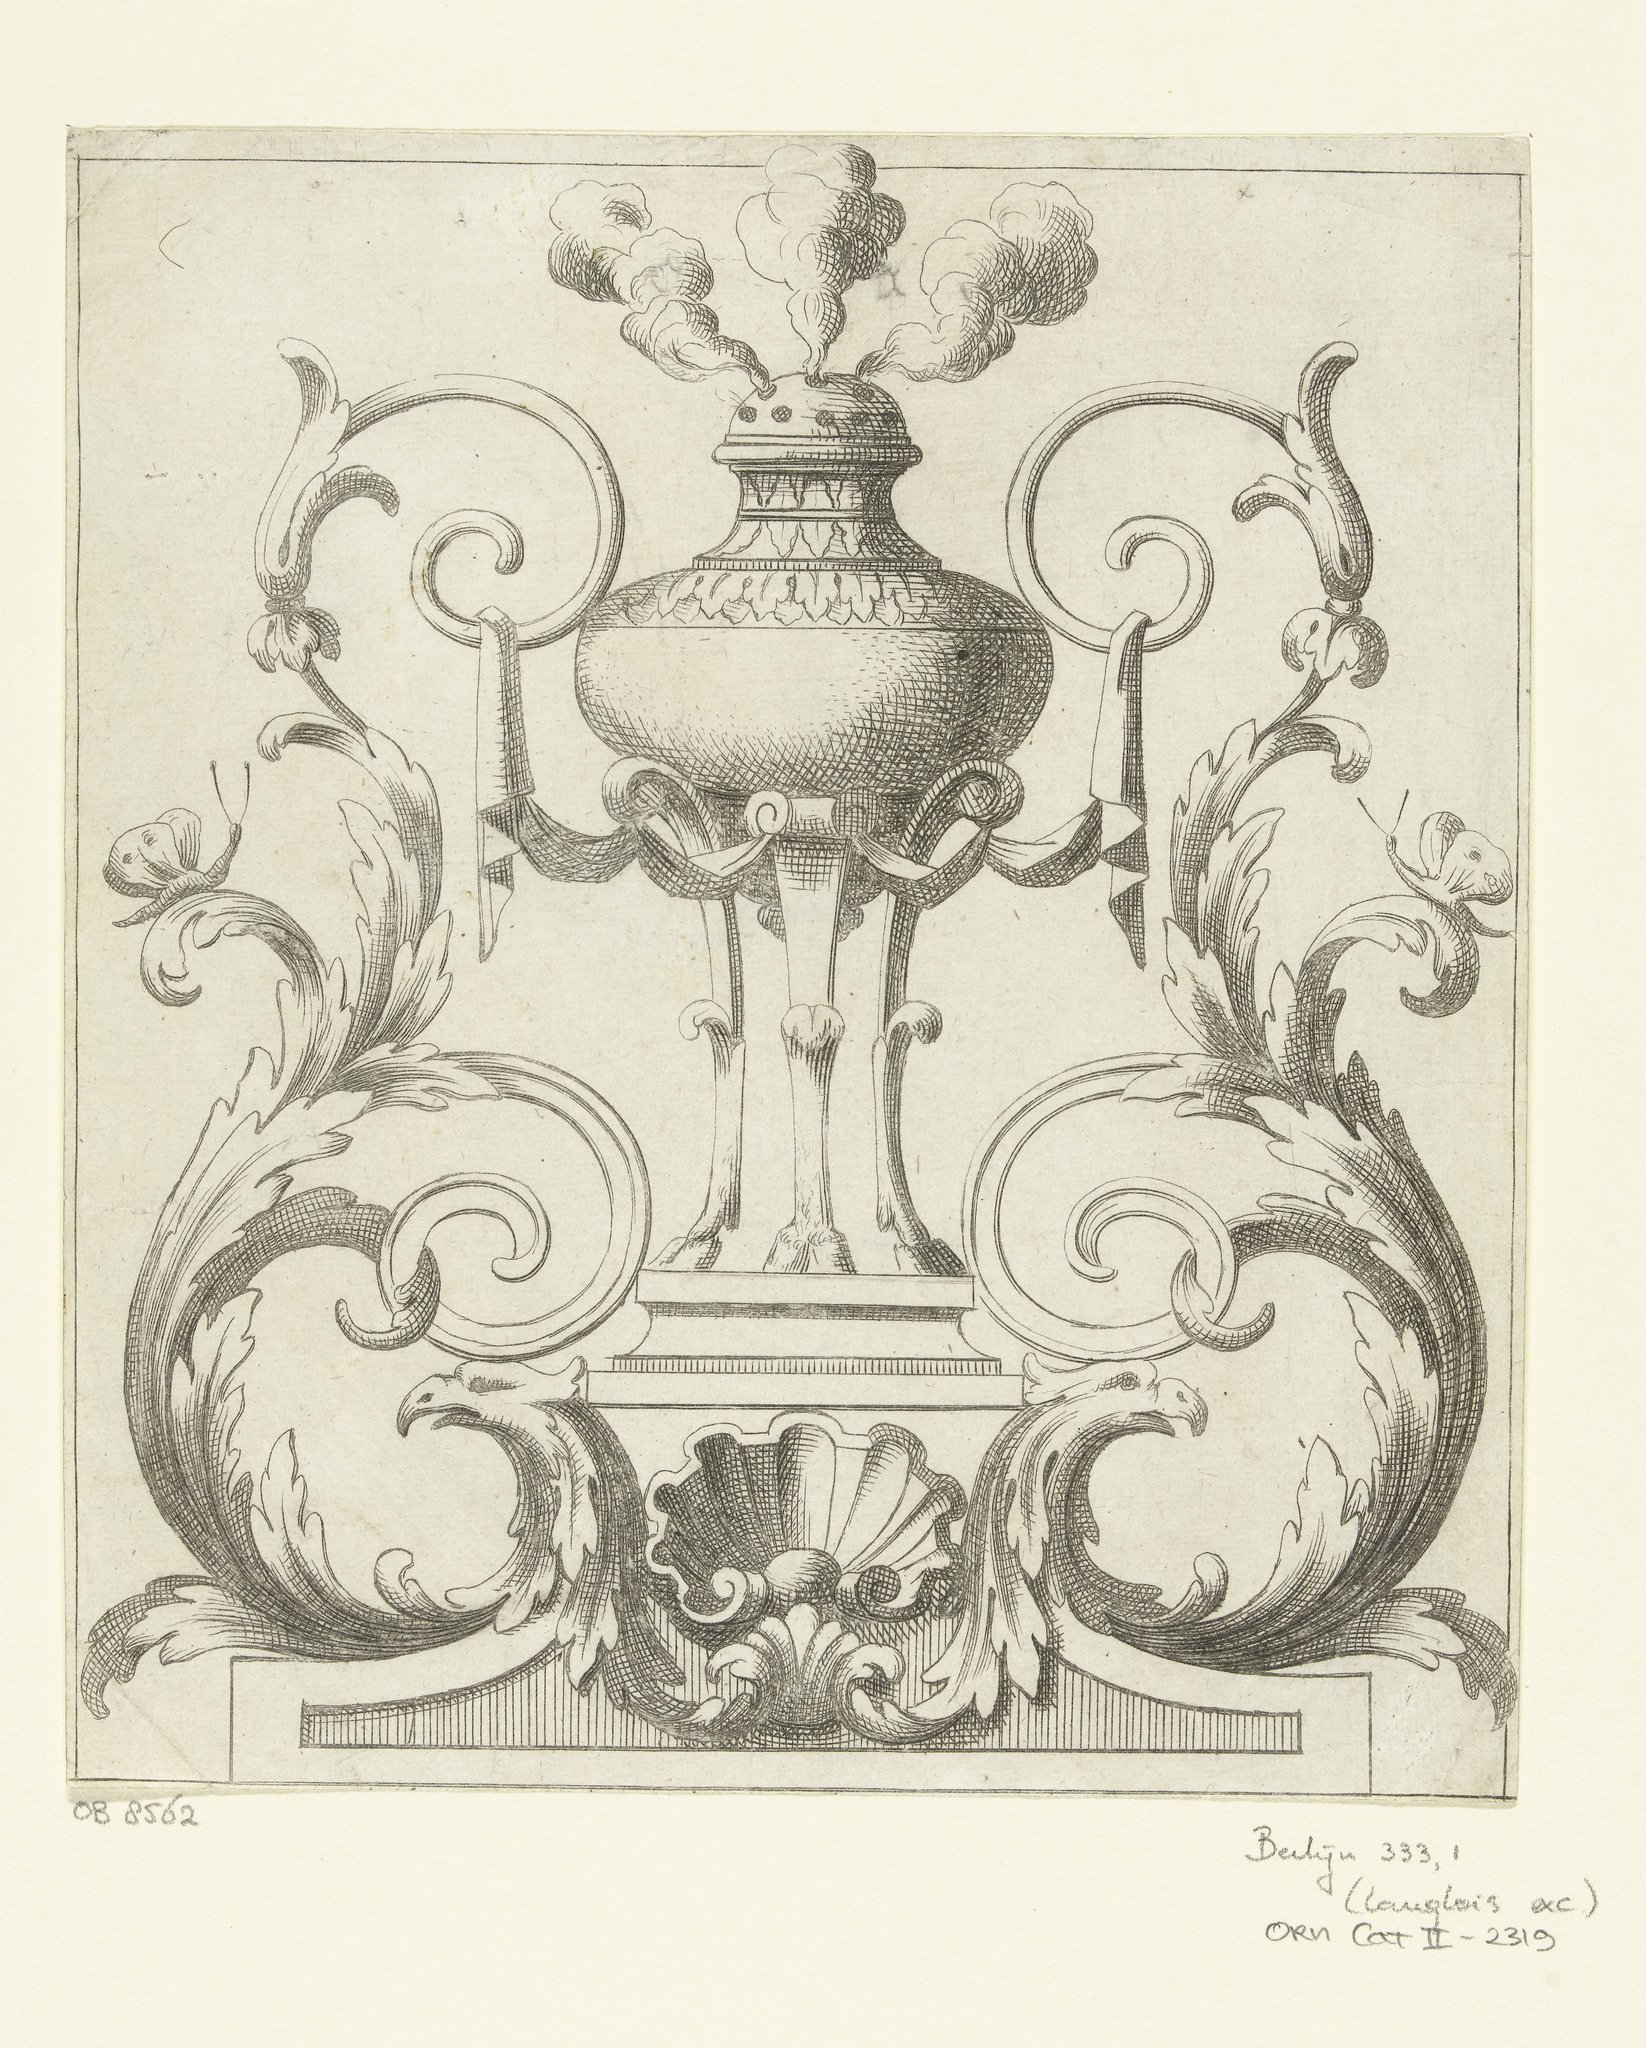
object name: ornament print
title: Wierookbrander op driepoot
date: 1680-1693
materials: paper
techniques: engraving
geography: france